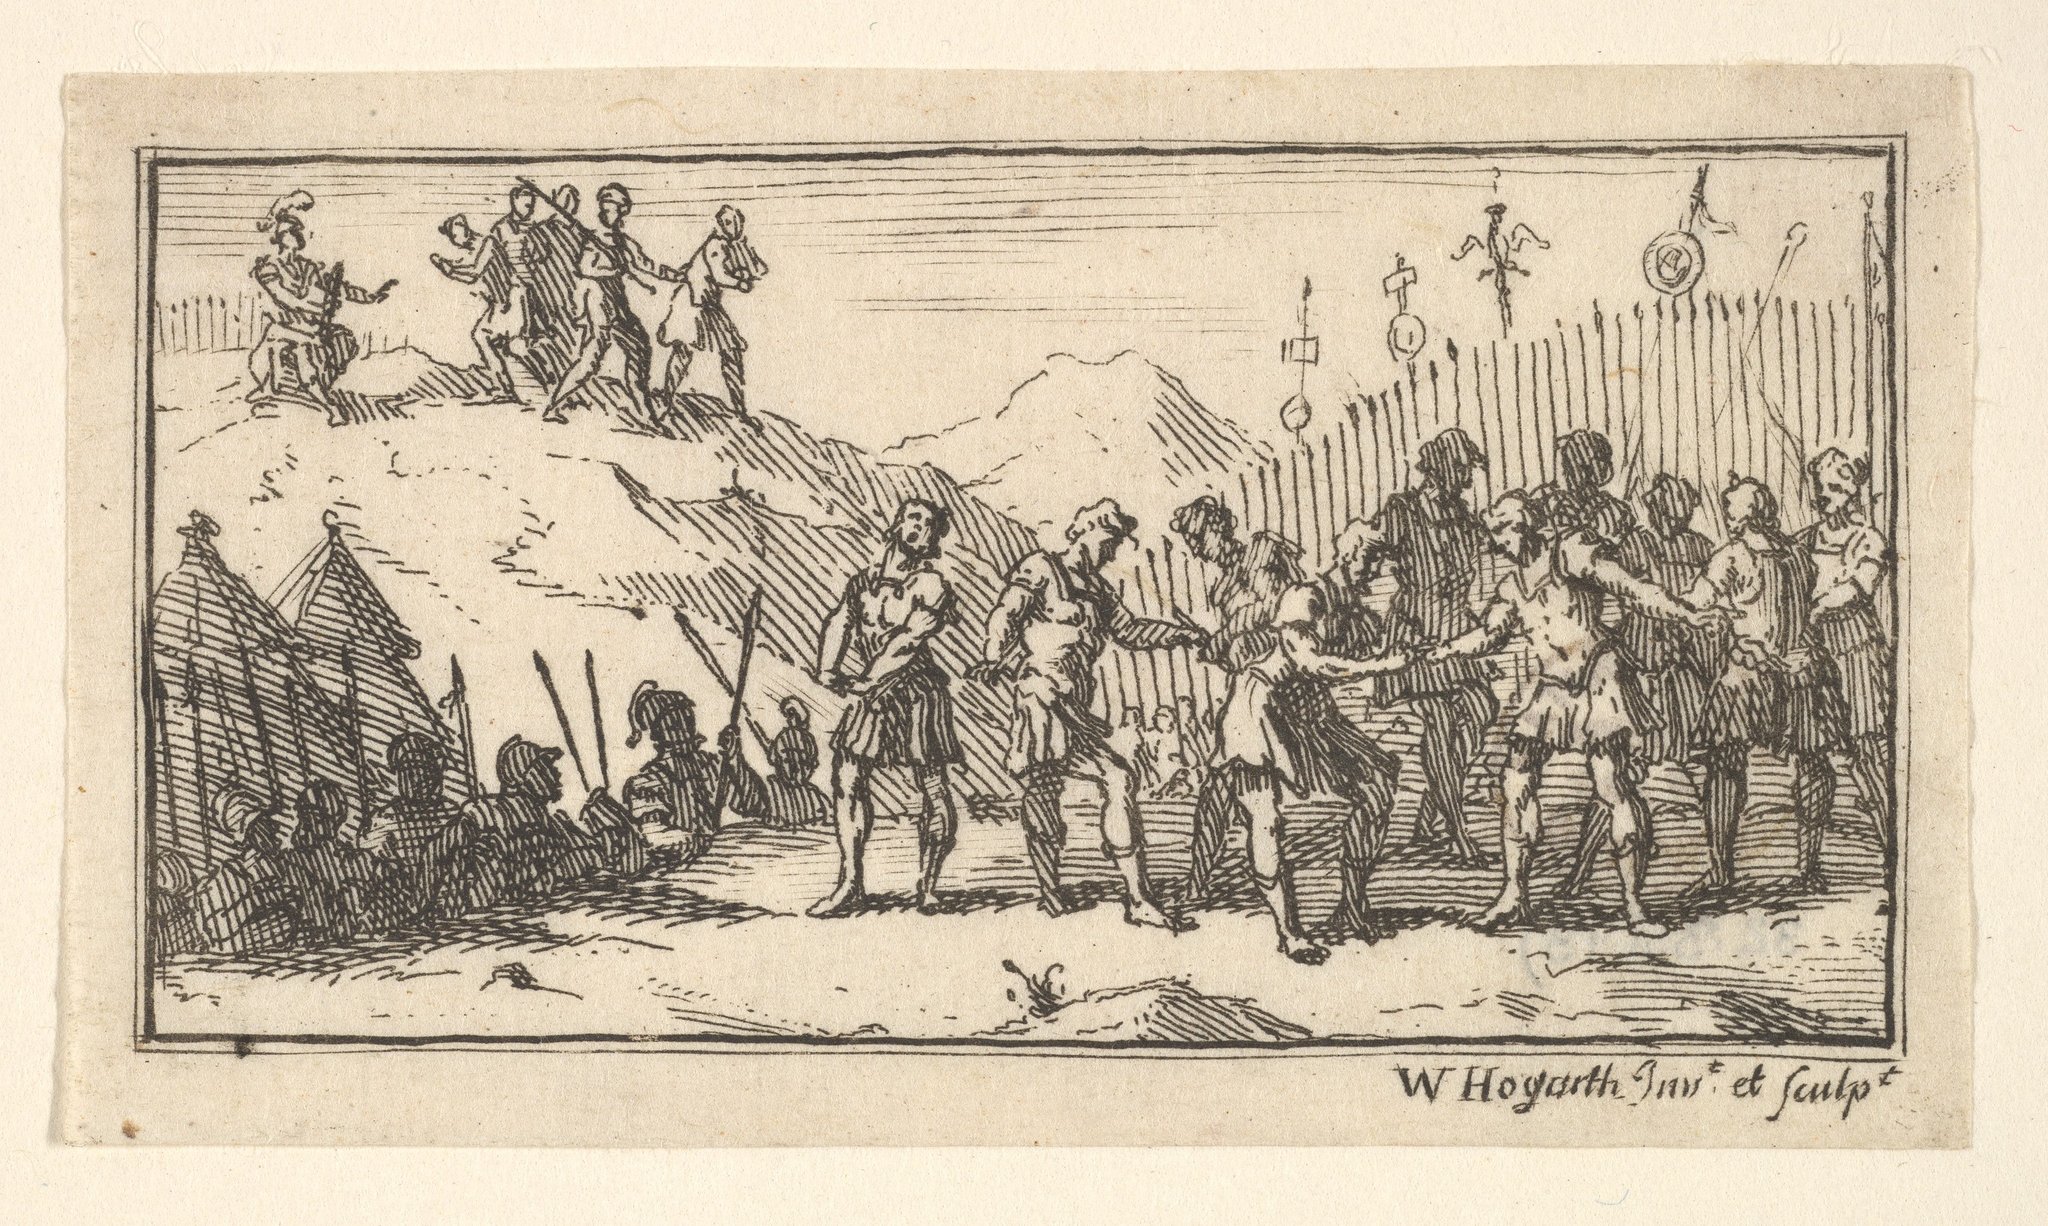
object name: print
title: Decimation (John Beaver, Roman Military Punishments, 1725)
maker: william hogarth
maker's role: artist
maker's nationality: british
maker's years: 1697-1764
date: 1725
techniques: etching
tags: human figures,soldiers,punishment